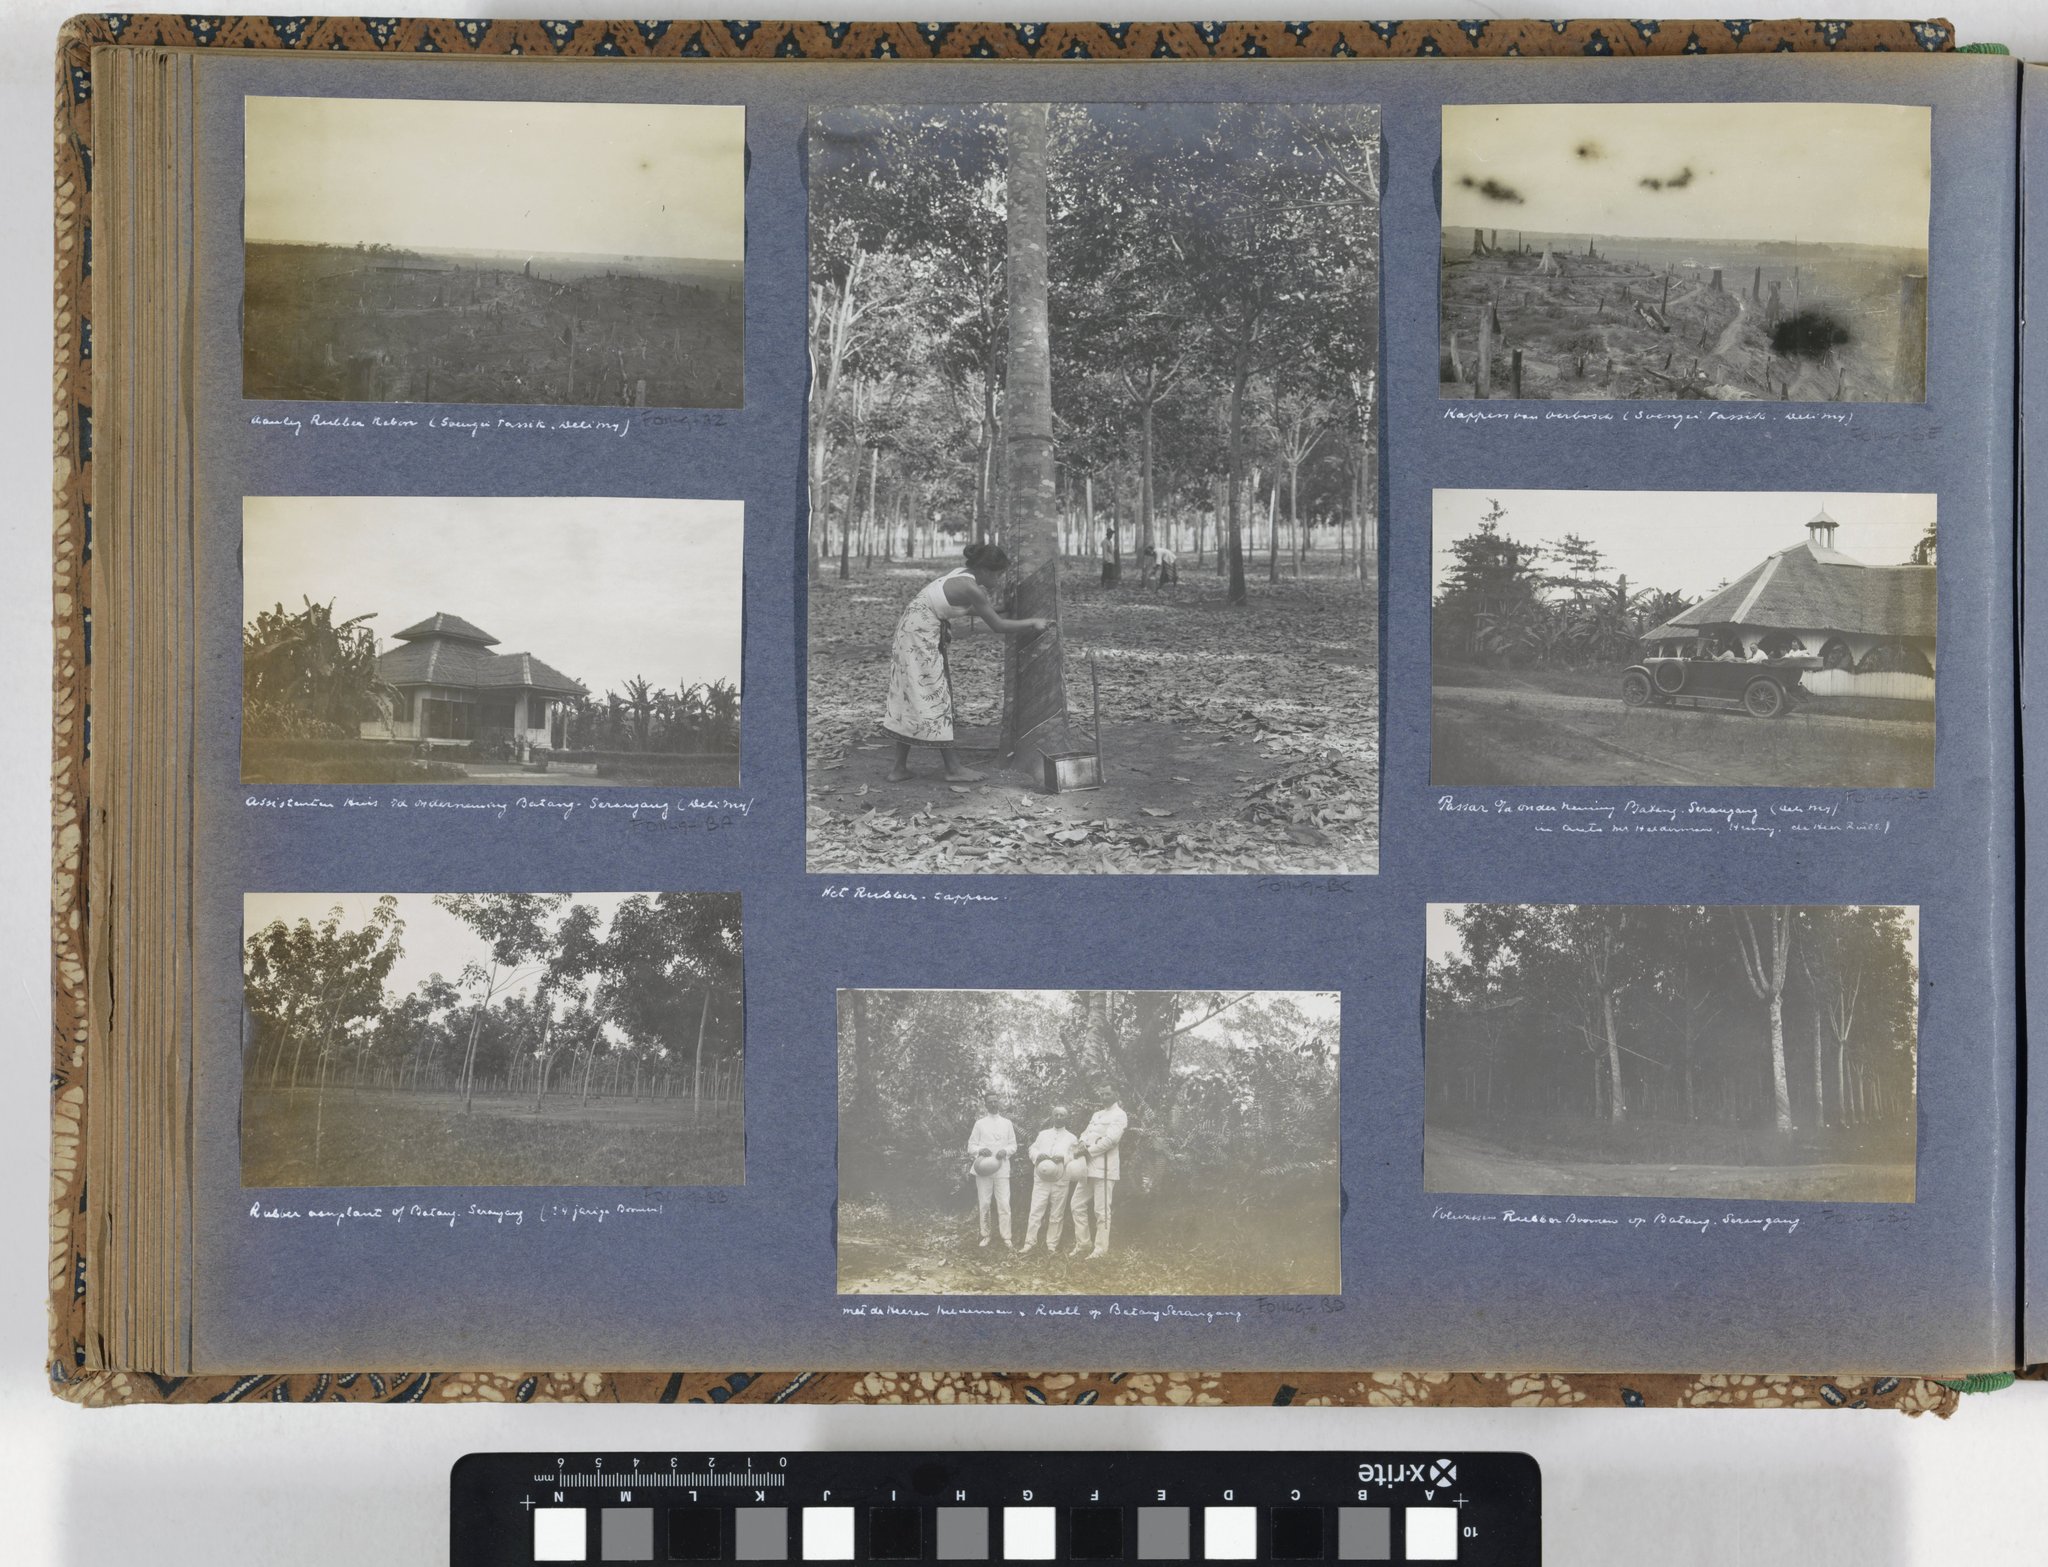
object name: photograph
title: Vrouwen tappen rubber op een plantage op Sumatra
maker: Anonymous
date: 1900-1920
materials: paper, photographic support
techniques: gelatin silver print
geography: sumatra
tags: plantation, (non-fruit) products of plants or trees: rubber, sumatra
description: Onderdeel van reisalbum met foto's van bedrijvigheid en bezienswaardigheden op Sumatra en Java en van de reis naar en van Nederlands-Indië.